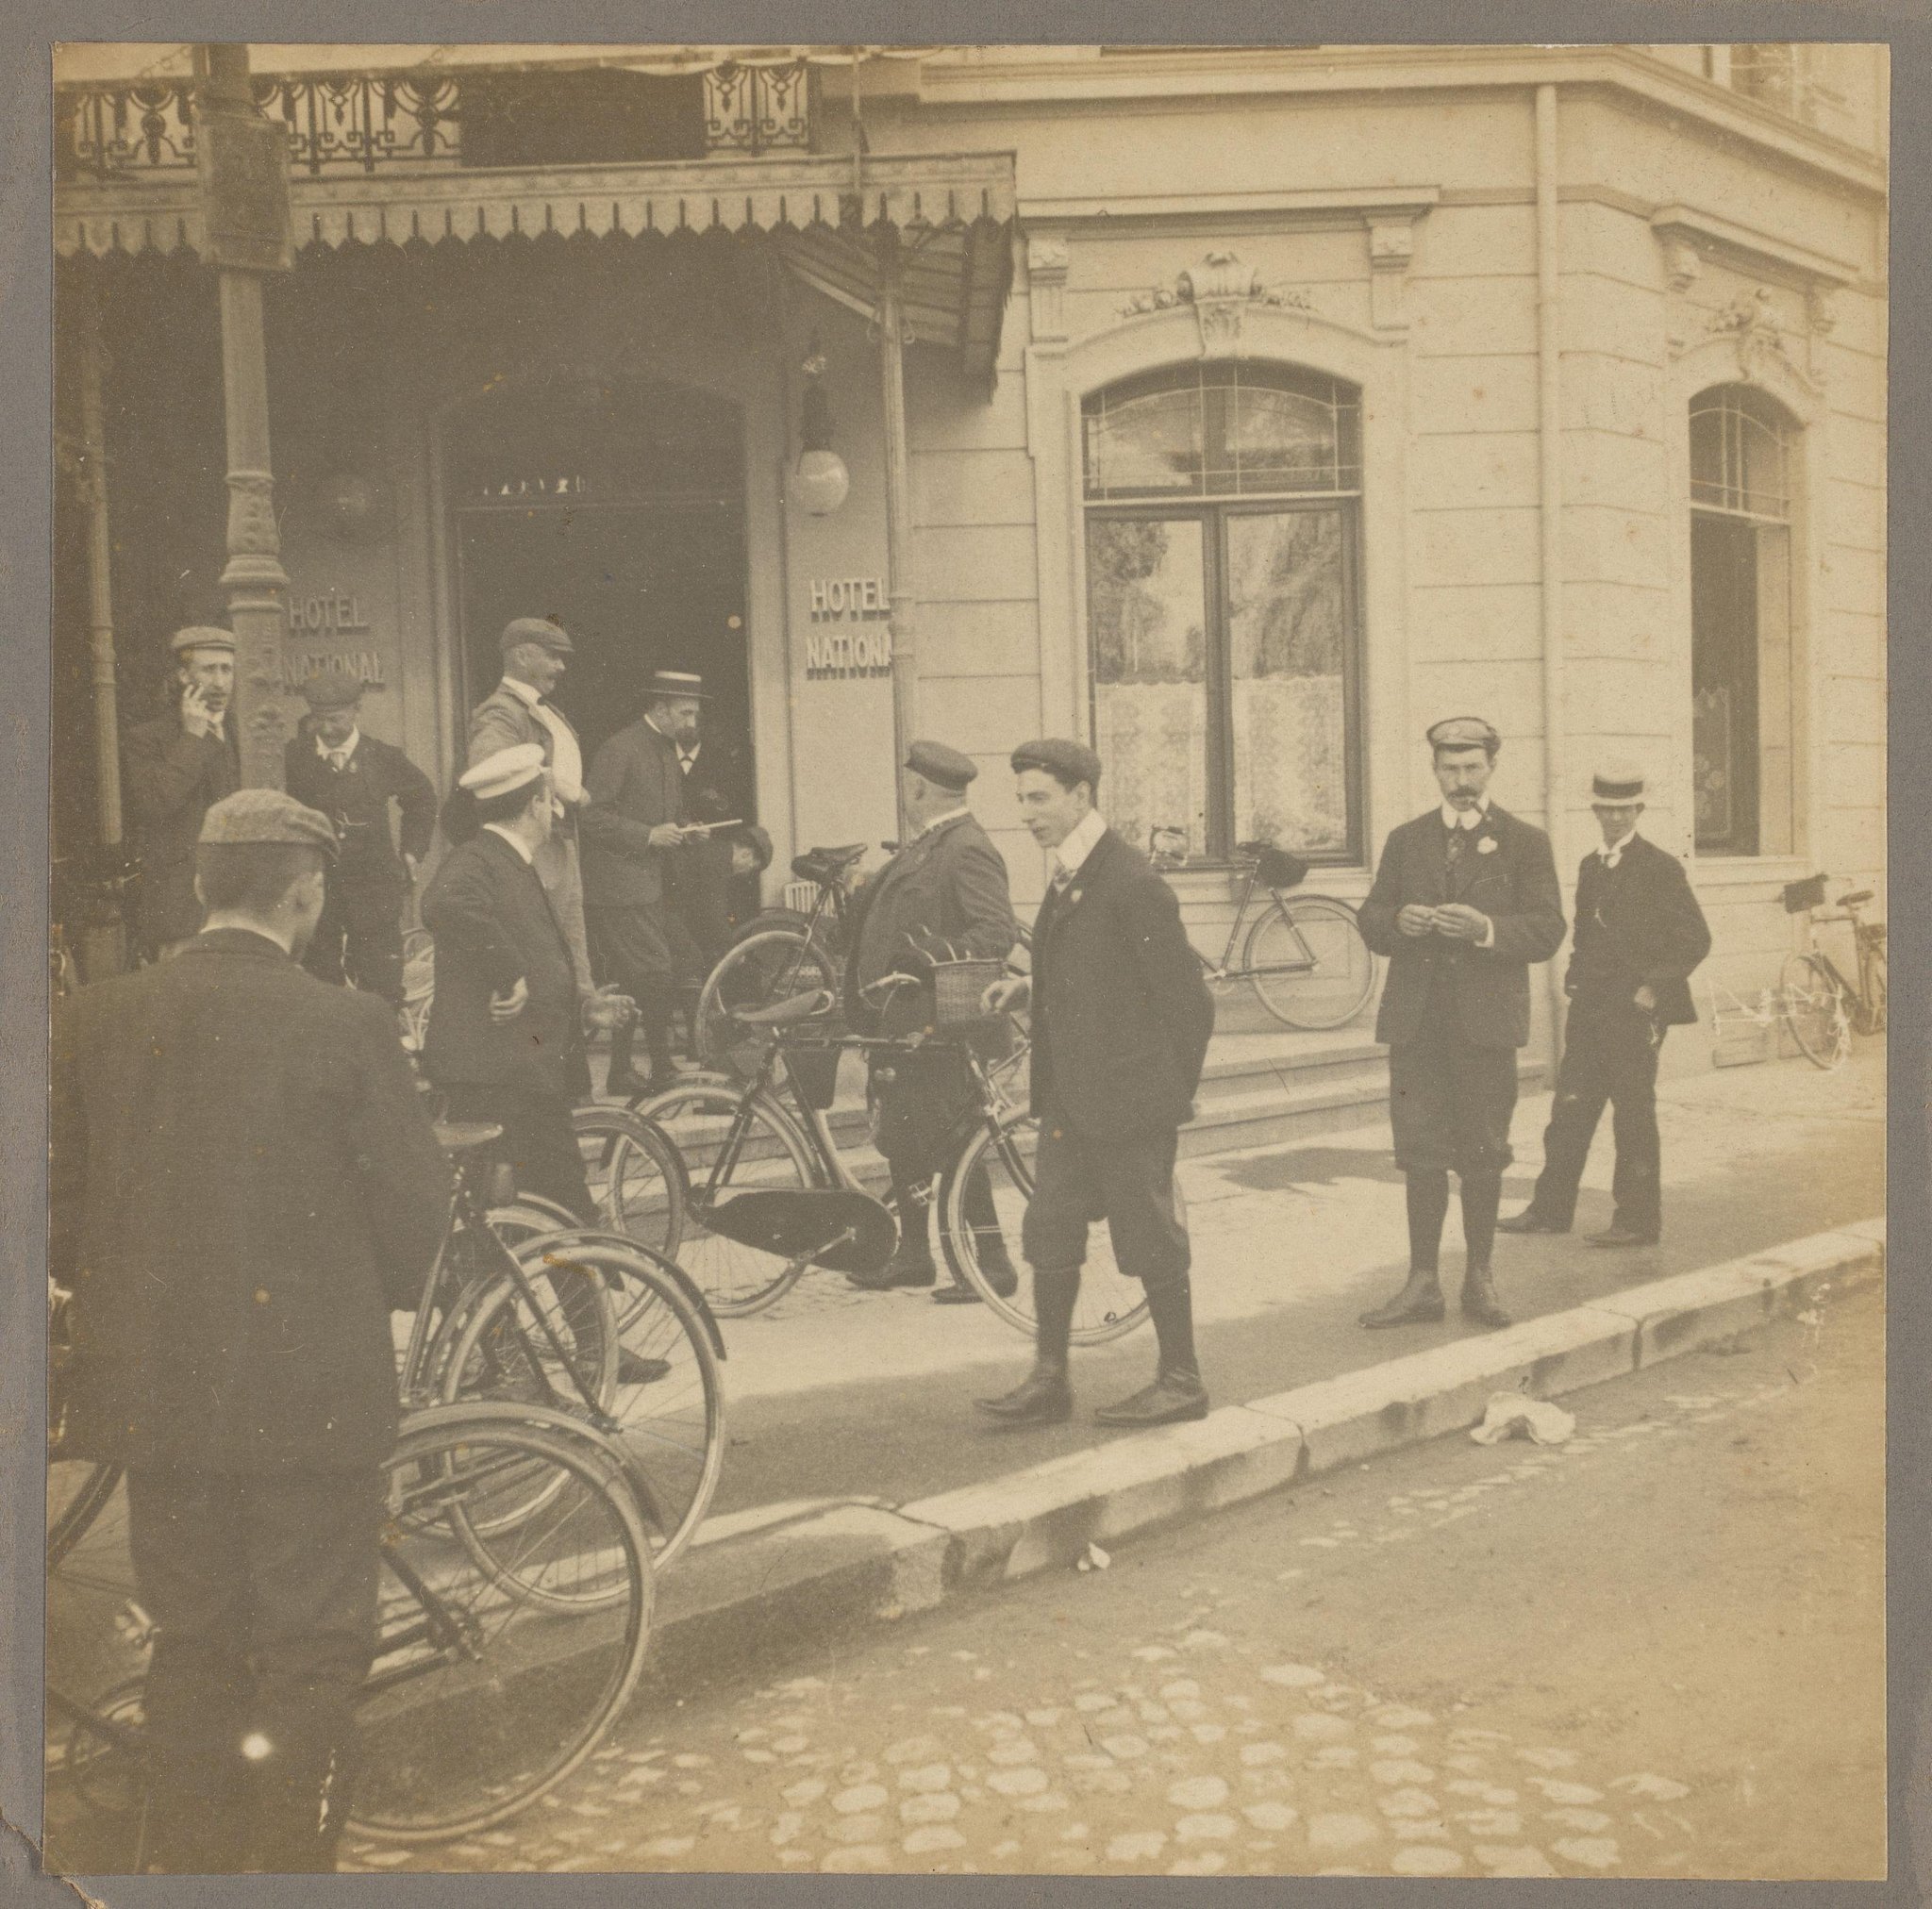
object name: photograph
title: Vertrek per fiets voor Hotel National, Bazel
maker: françois buys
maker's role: advocaat, amateurfotograaf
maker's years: 1871-1934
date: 1905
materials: paper, cardboard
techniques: gelatin silver print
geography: basel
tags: bicycle, departure ~ travelling, hotel, hostelry, inn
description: Deze foto maakt deel uit van een groep van 38 foto's.